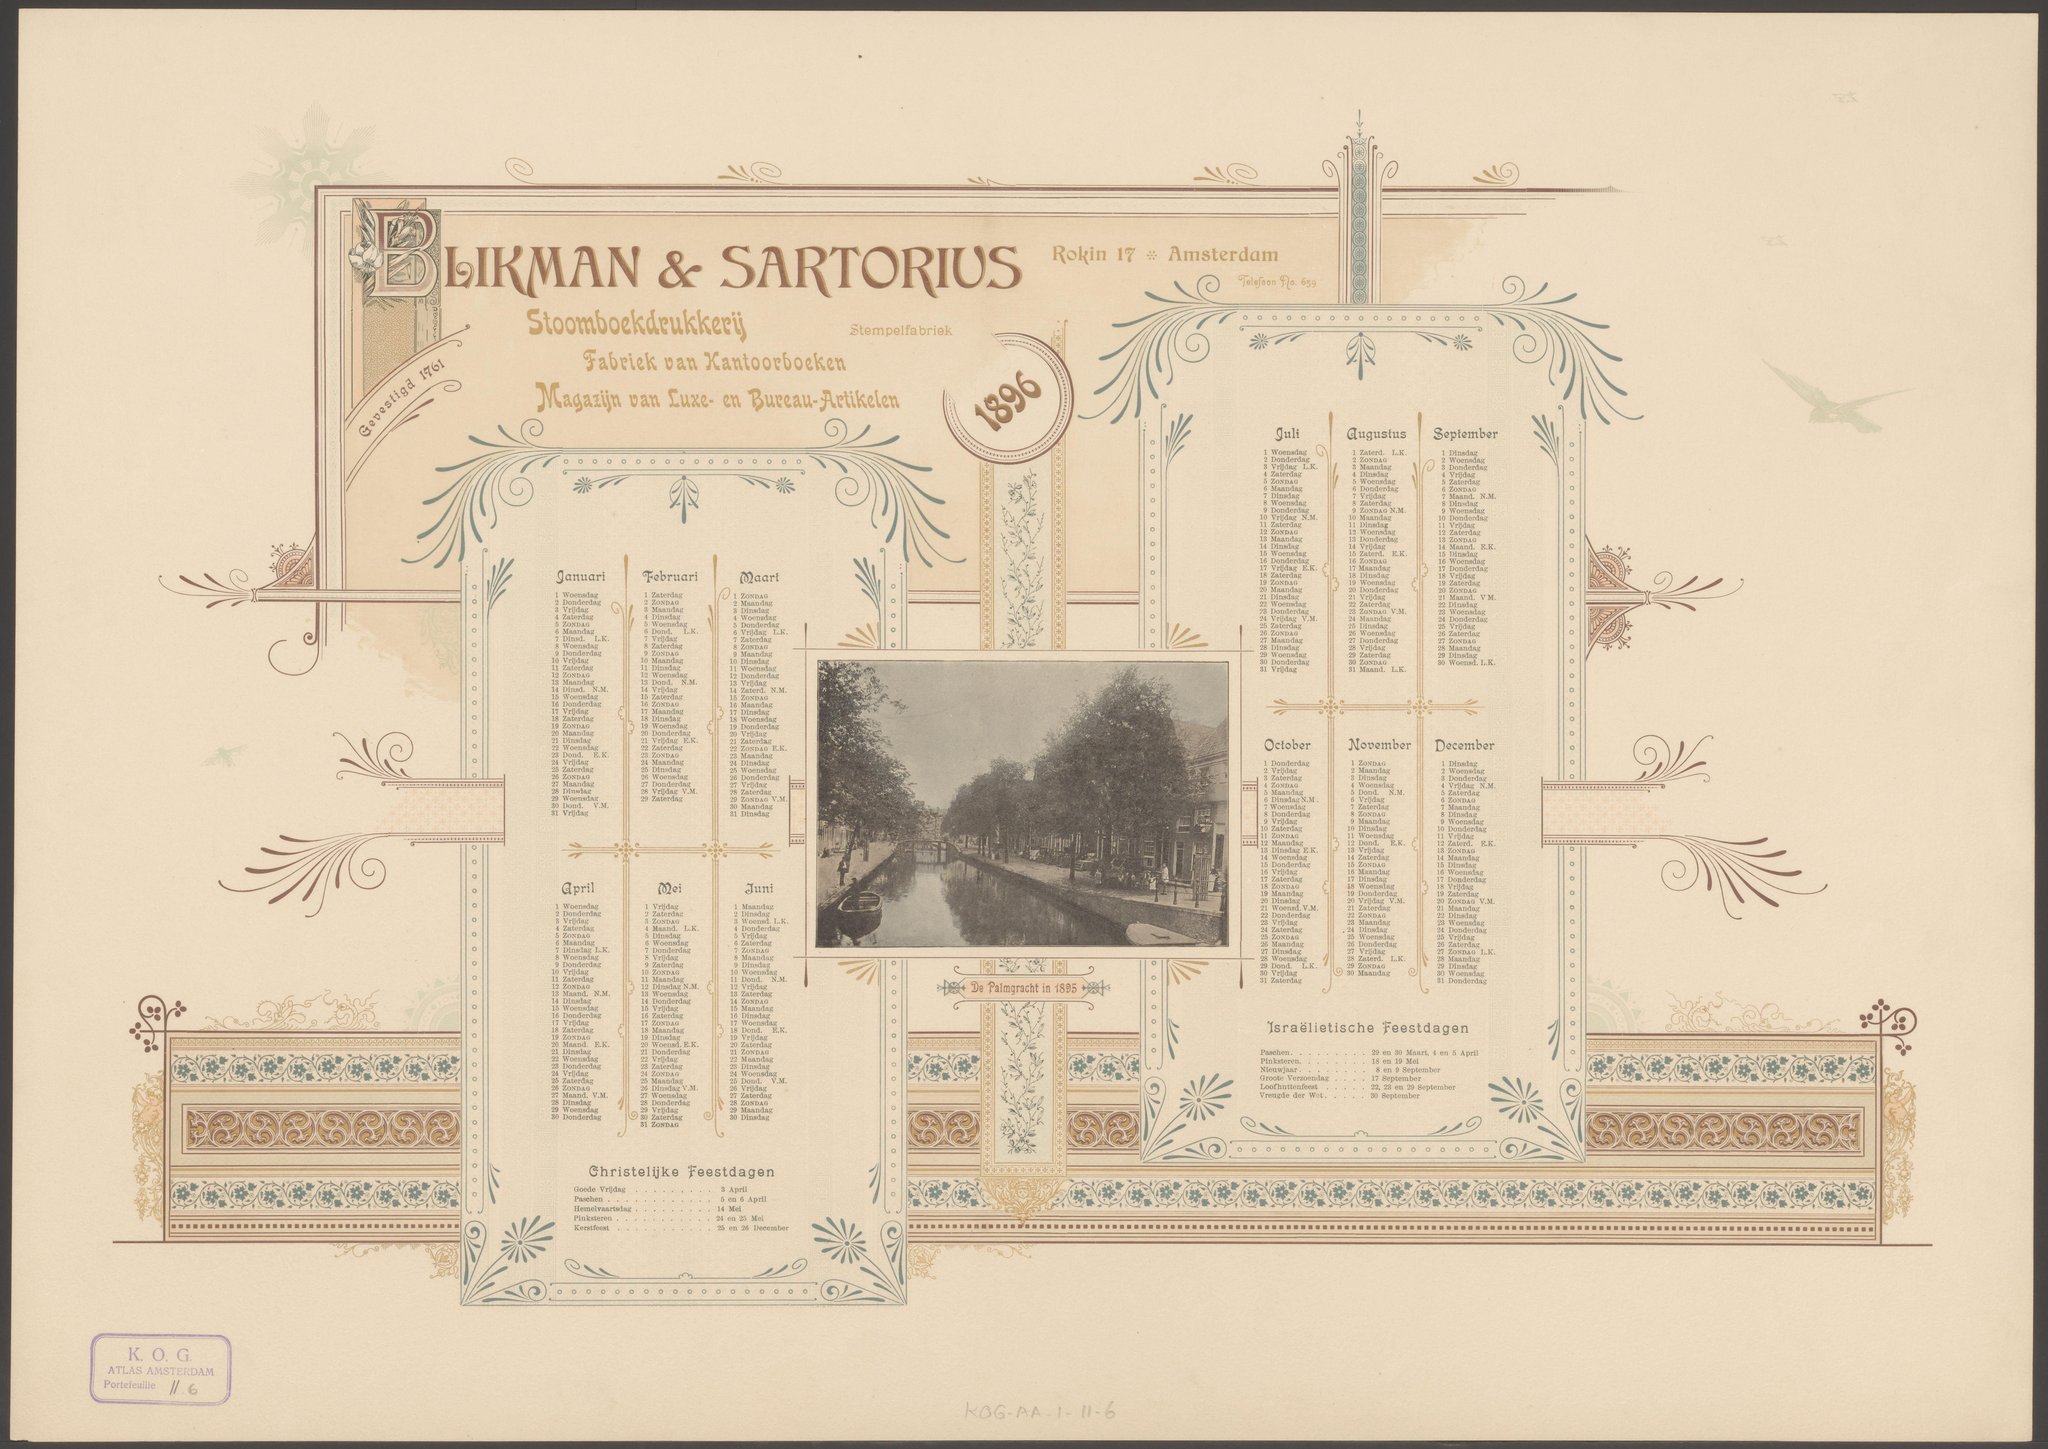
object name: print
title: Kalender voor het jaar 1896 met gezicht op de Palmgracht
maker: Anonymous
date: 1896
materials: paper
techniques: lithograph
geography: amsterdam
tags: city-view in general; 'veduta', canal, the usual house or row of houses, bridge in city across river, canal, etc., street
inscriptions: collector's mark: ‘11.6’ Lugt 1641b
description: Onderwerpsrubriek binnen de Atlas Amsterdam: Paleisstraat, Palmgracht, Papenbrugsteeg, Passeerdersgracht, Peperstraat, Pieterspoort (St.), Pieterssteeg (St.), Plantage, Prinseneiland.